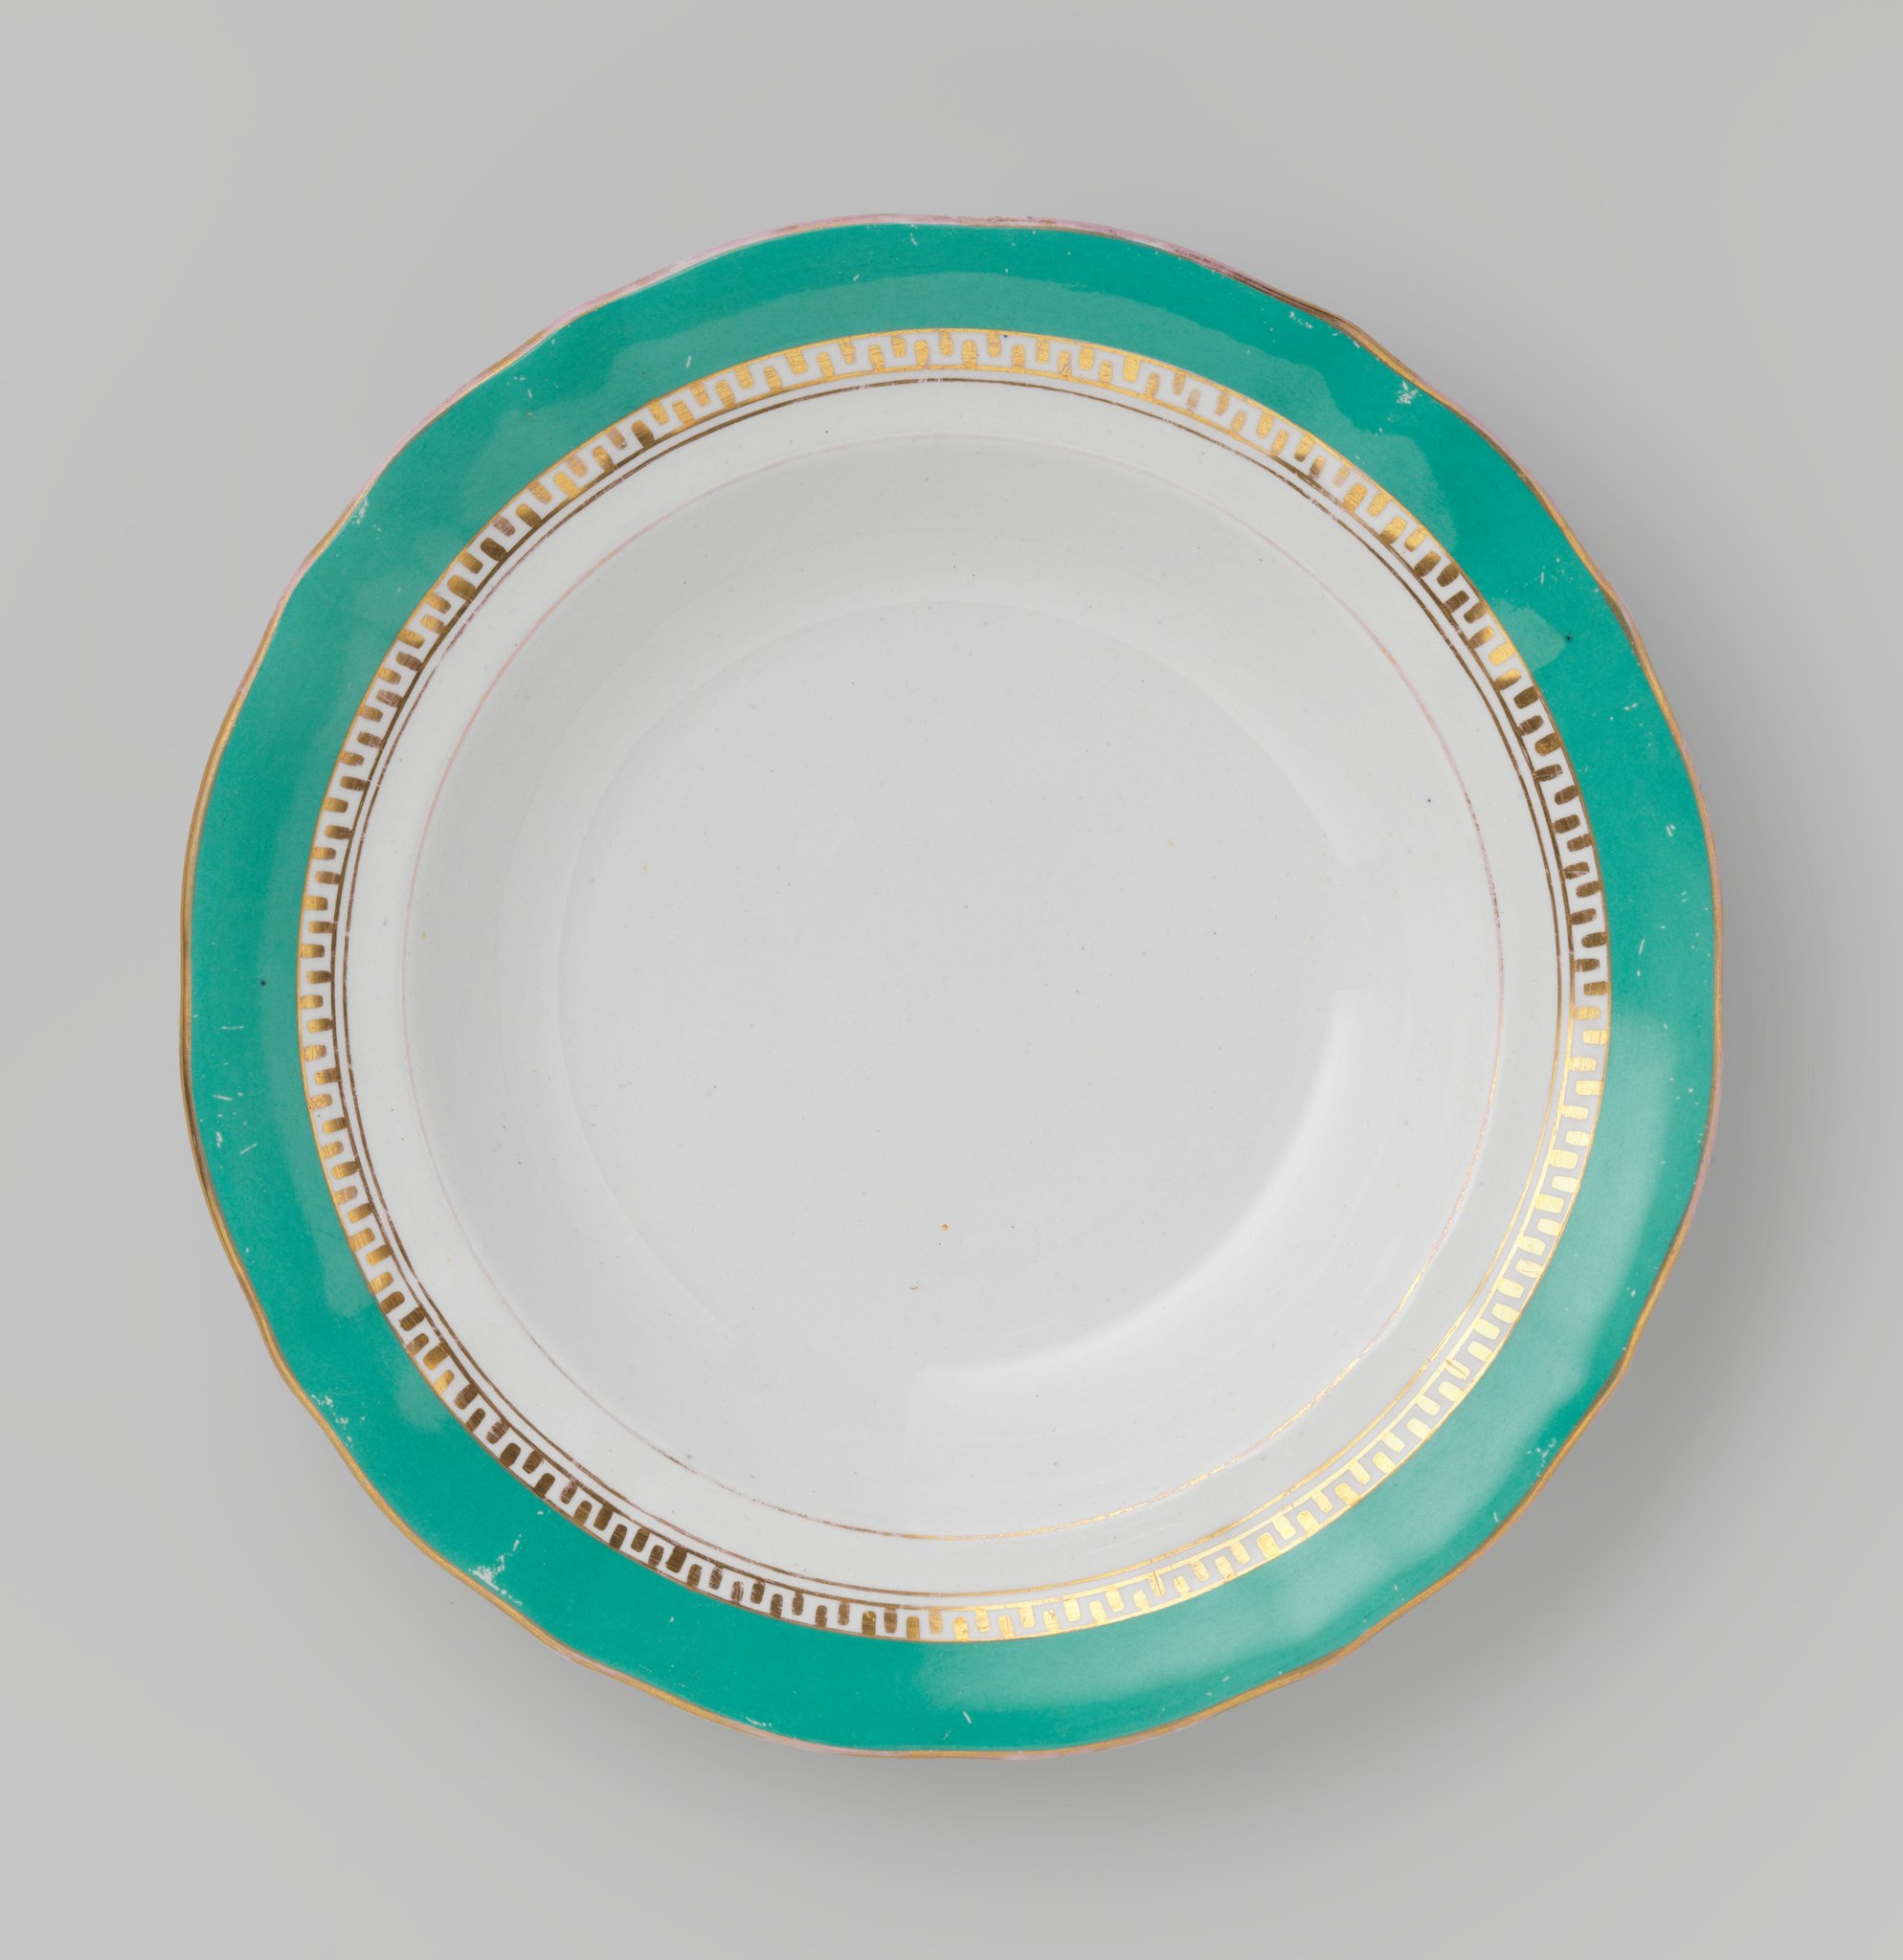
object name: plate dish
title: Bord met groene rand en gouden Griekse band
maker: petrus regout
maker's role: plateelbakker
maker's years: 1801-1879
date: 1865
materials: earthenware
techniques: transfer decoration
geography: maastricht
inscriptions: check stamp: ‘P. REGOUT // MAASTRICHT // 8X’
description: Bord van aardewerk, geschulpt, met groene rand en gouden Griekse band.